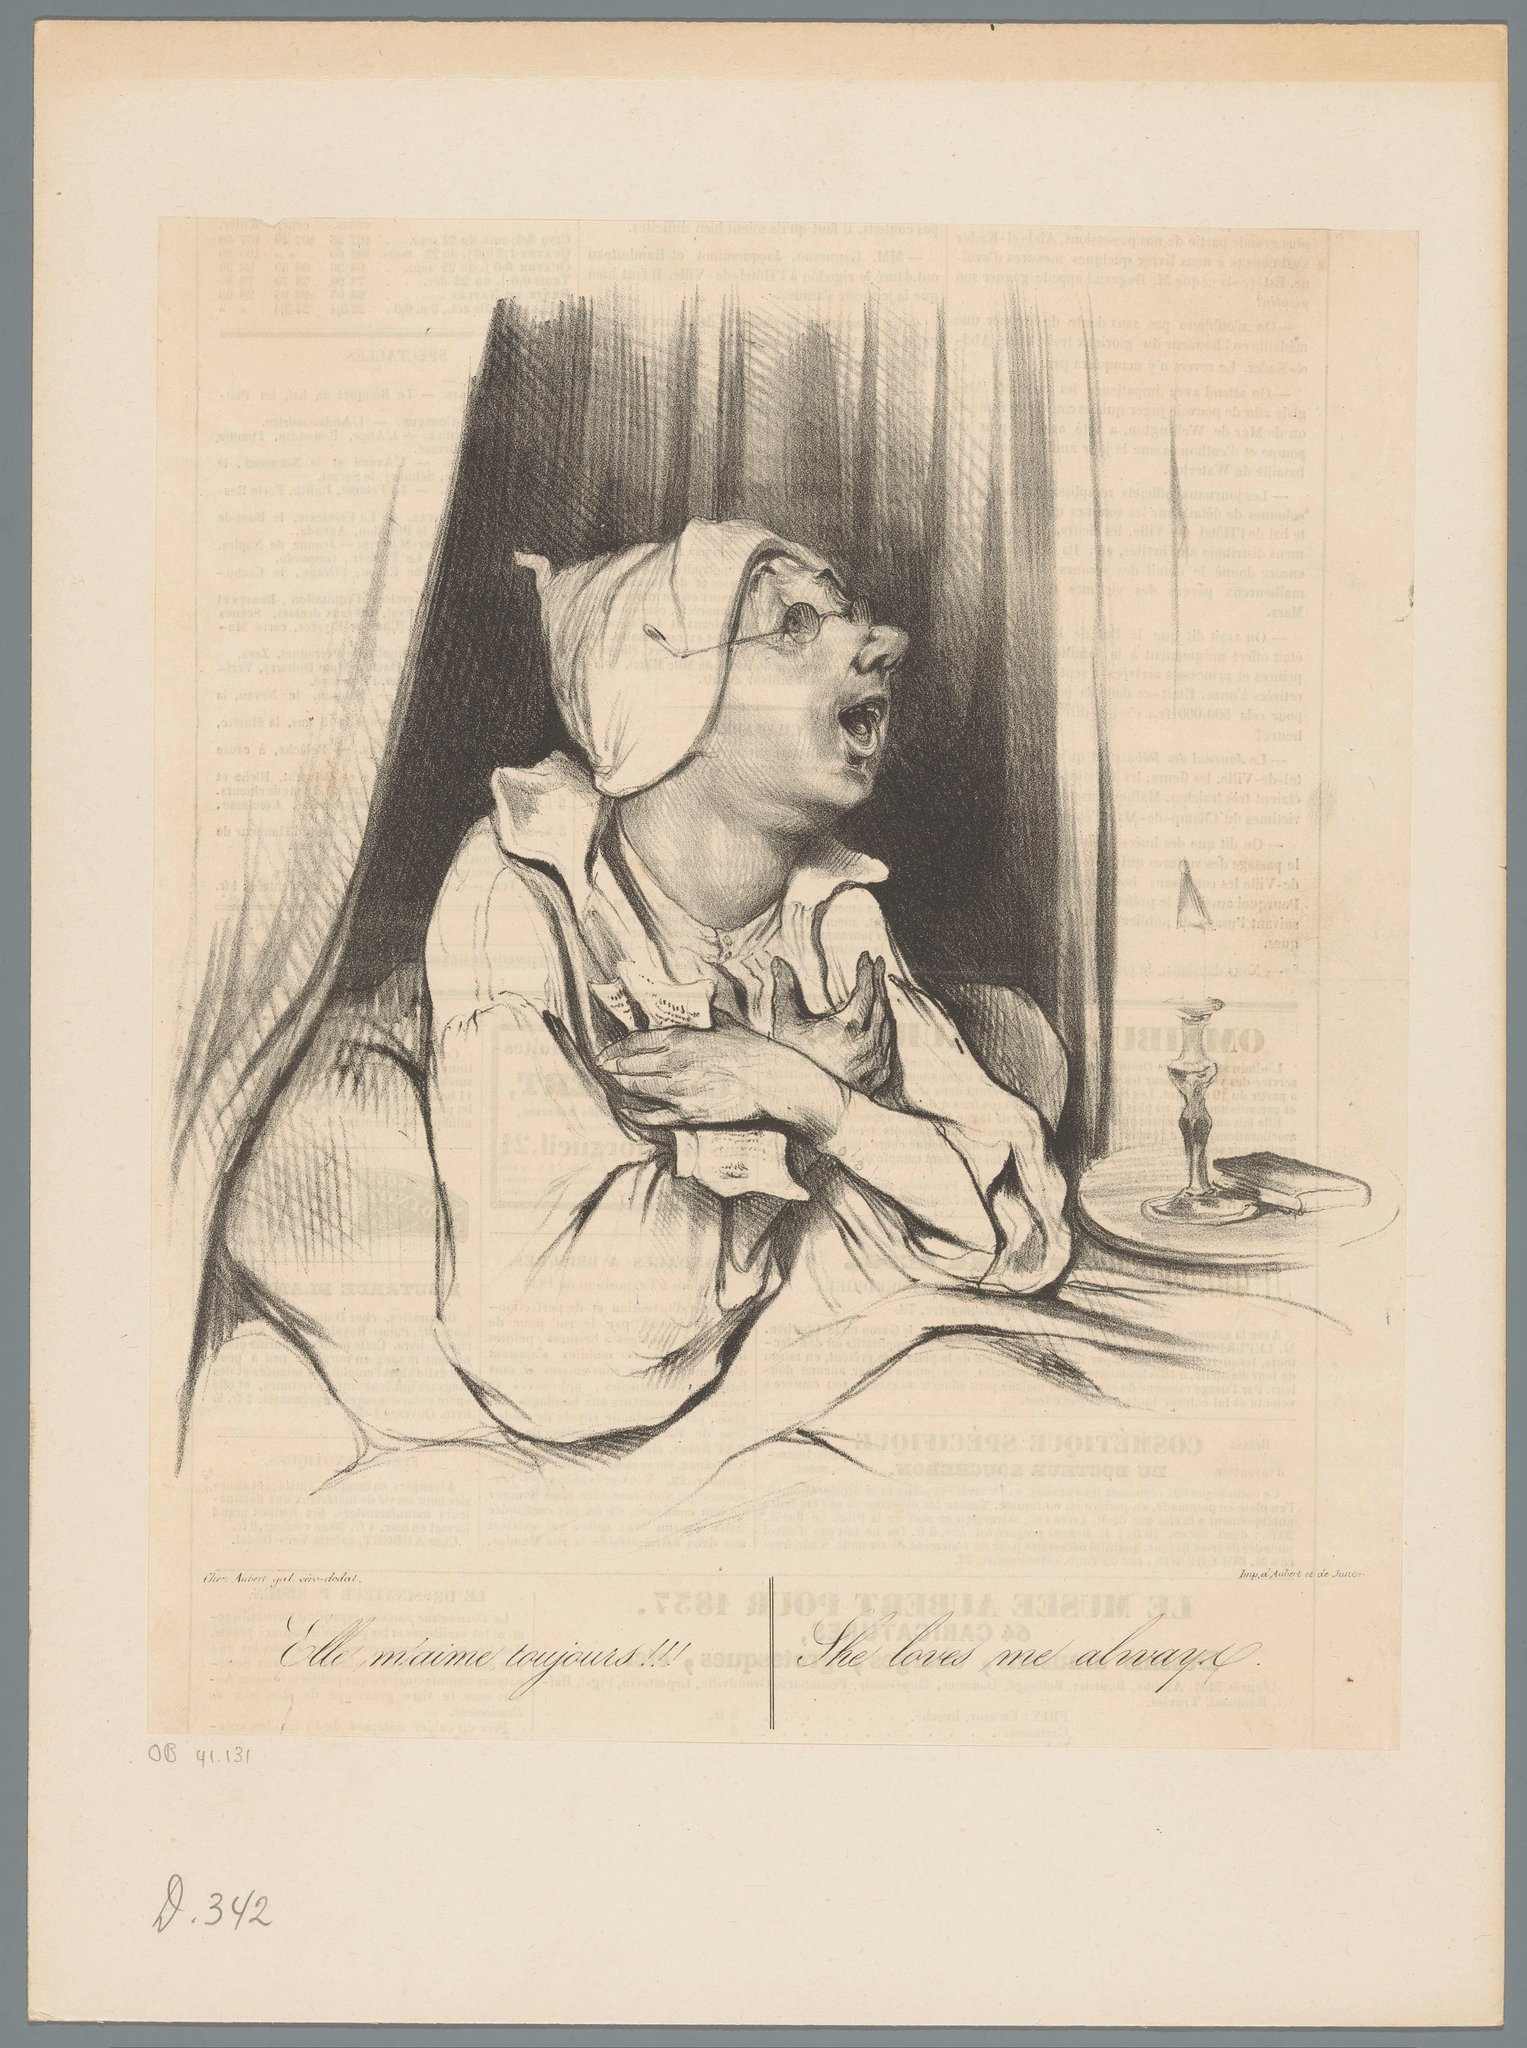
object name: cartoon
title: Galerie physionomique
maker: honoré daumier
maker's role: draughtsman, painter, print maker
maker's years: 1808-1879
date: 1837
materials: paper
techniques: letterpress printing, lithograph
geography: paris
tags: caricatures (human types), nightwear: night-gown, lover with love-letter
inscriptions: collector's mark: Lugt 2228a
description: Prent mogelijk uit: Le Charivari, 22 juni 1837.